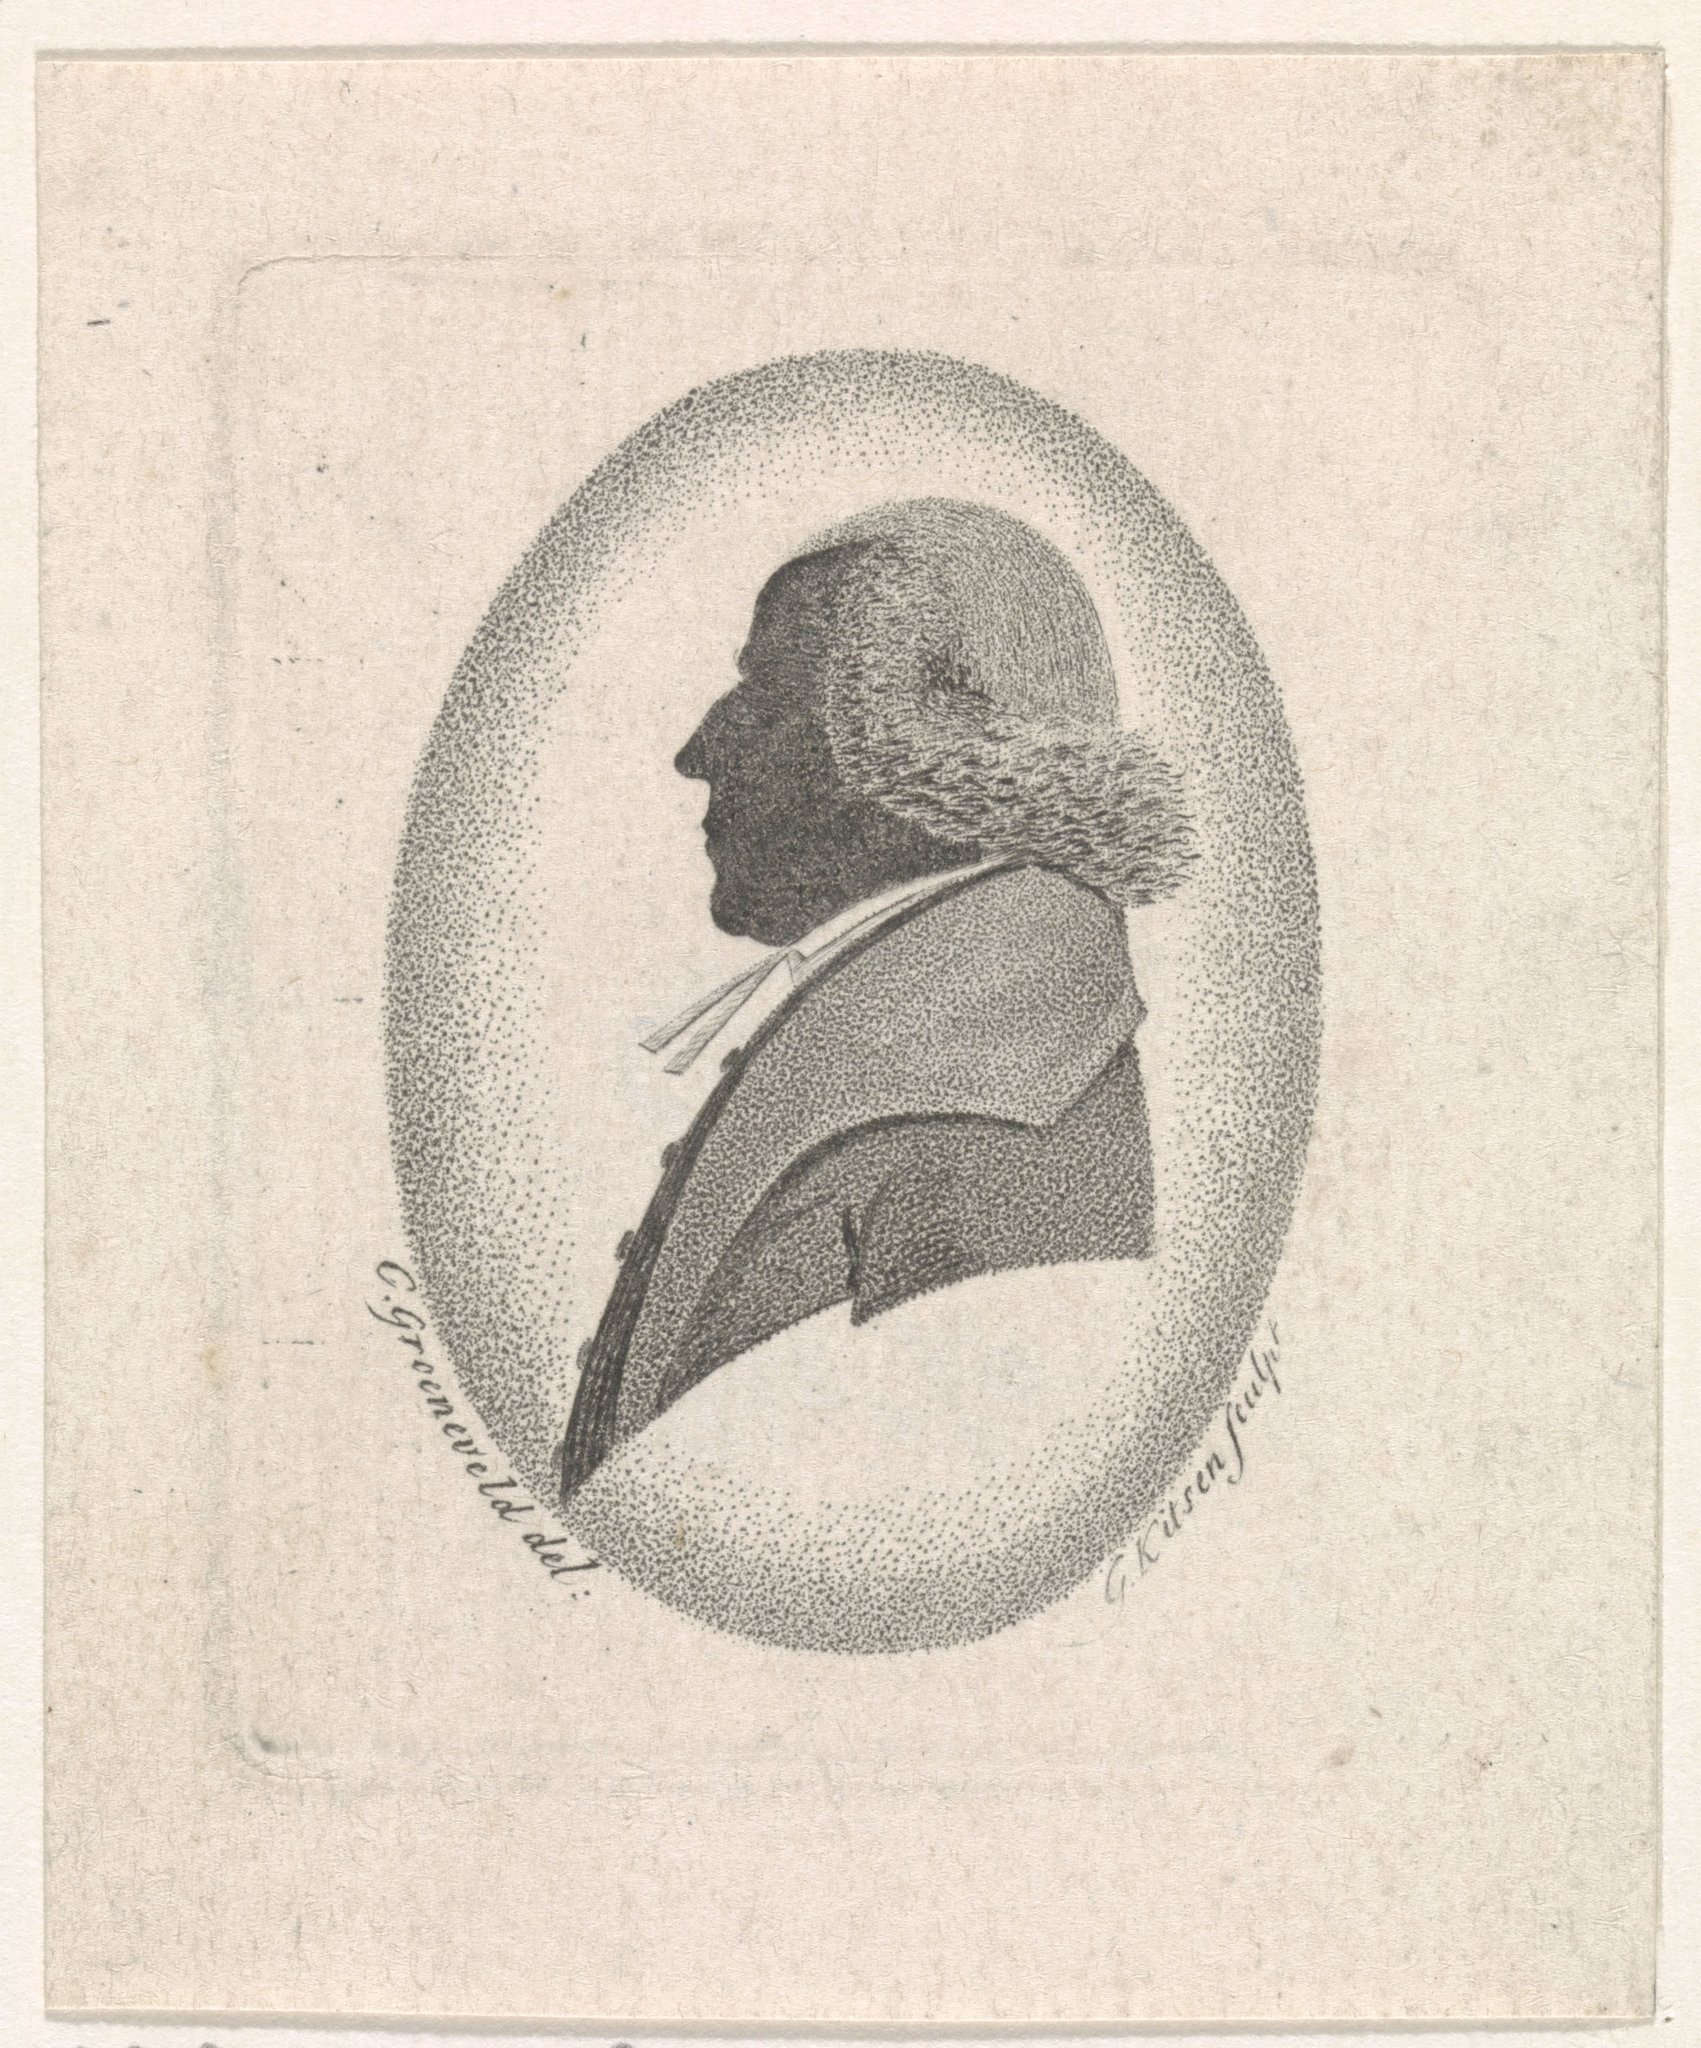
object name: print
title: Silhouetportret van Jan Scharp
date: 1776-1810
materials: paper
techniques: engraving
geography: rotterdam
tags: the hague, rotterdam, jan scharp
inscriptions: collector's mark: Lugt 2228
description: Portretbuste van Jan Scharp, dichter en predikant te Rotterdam.